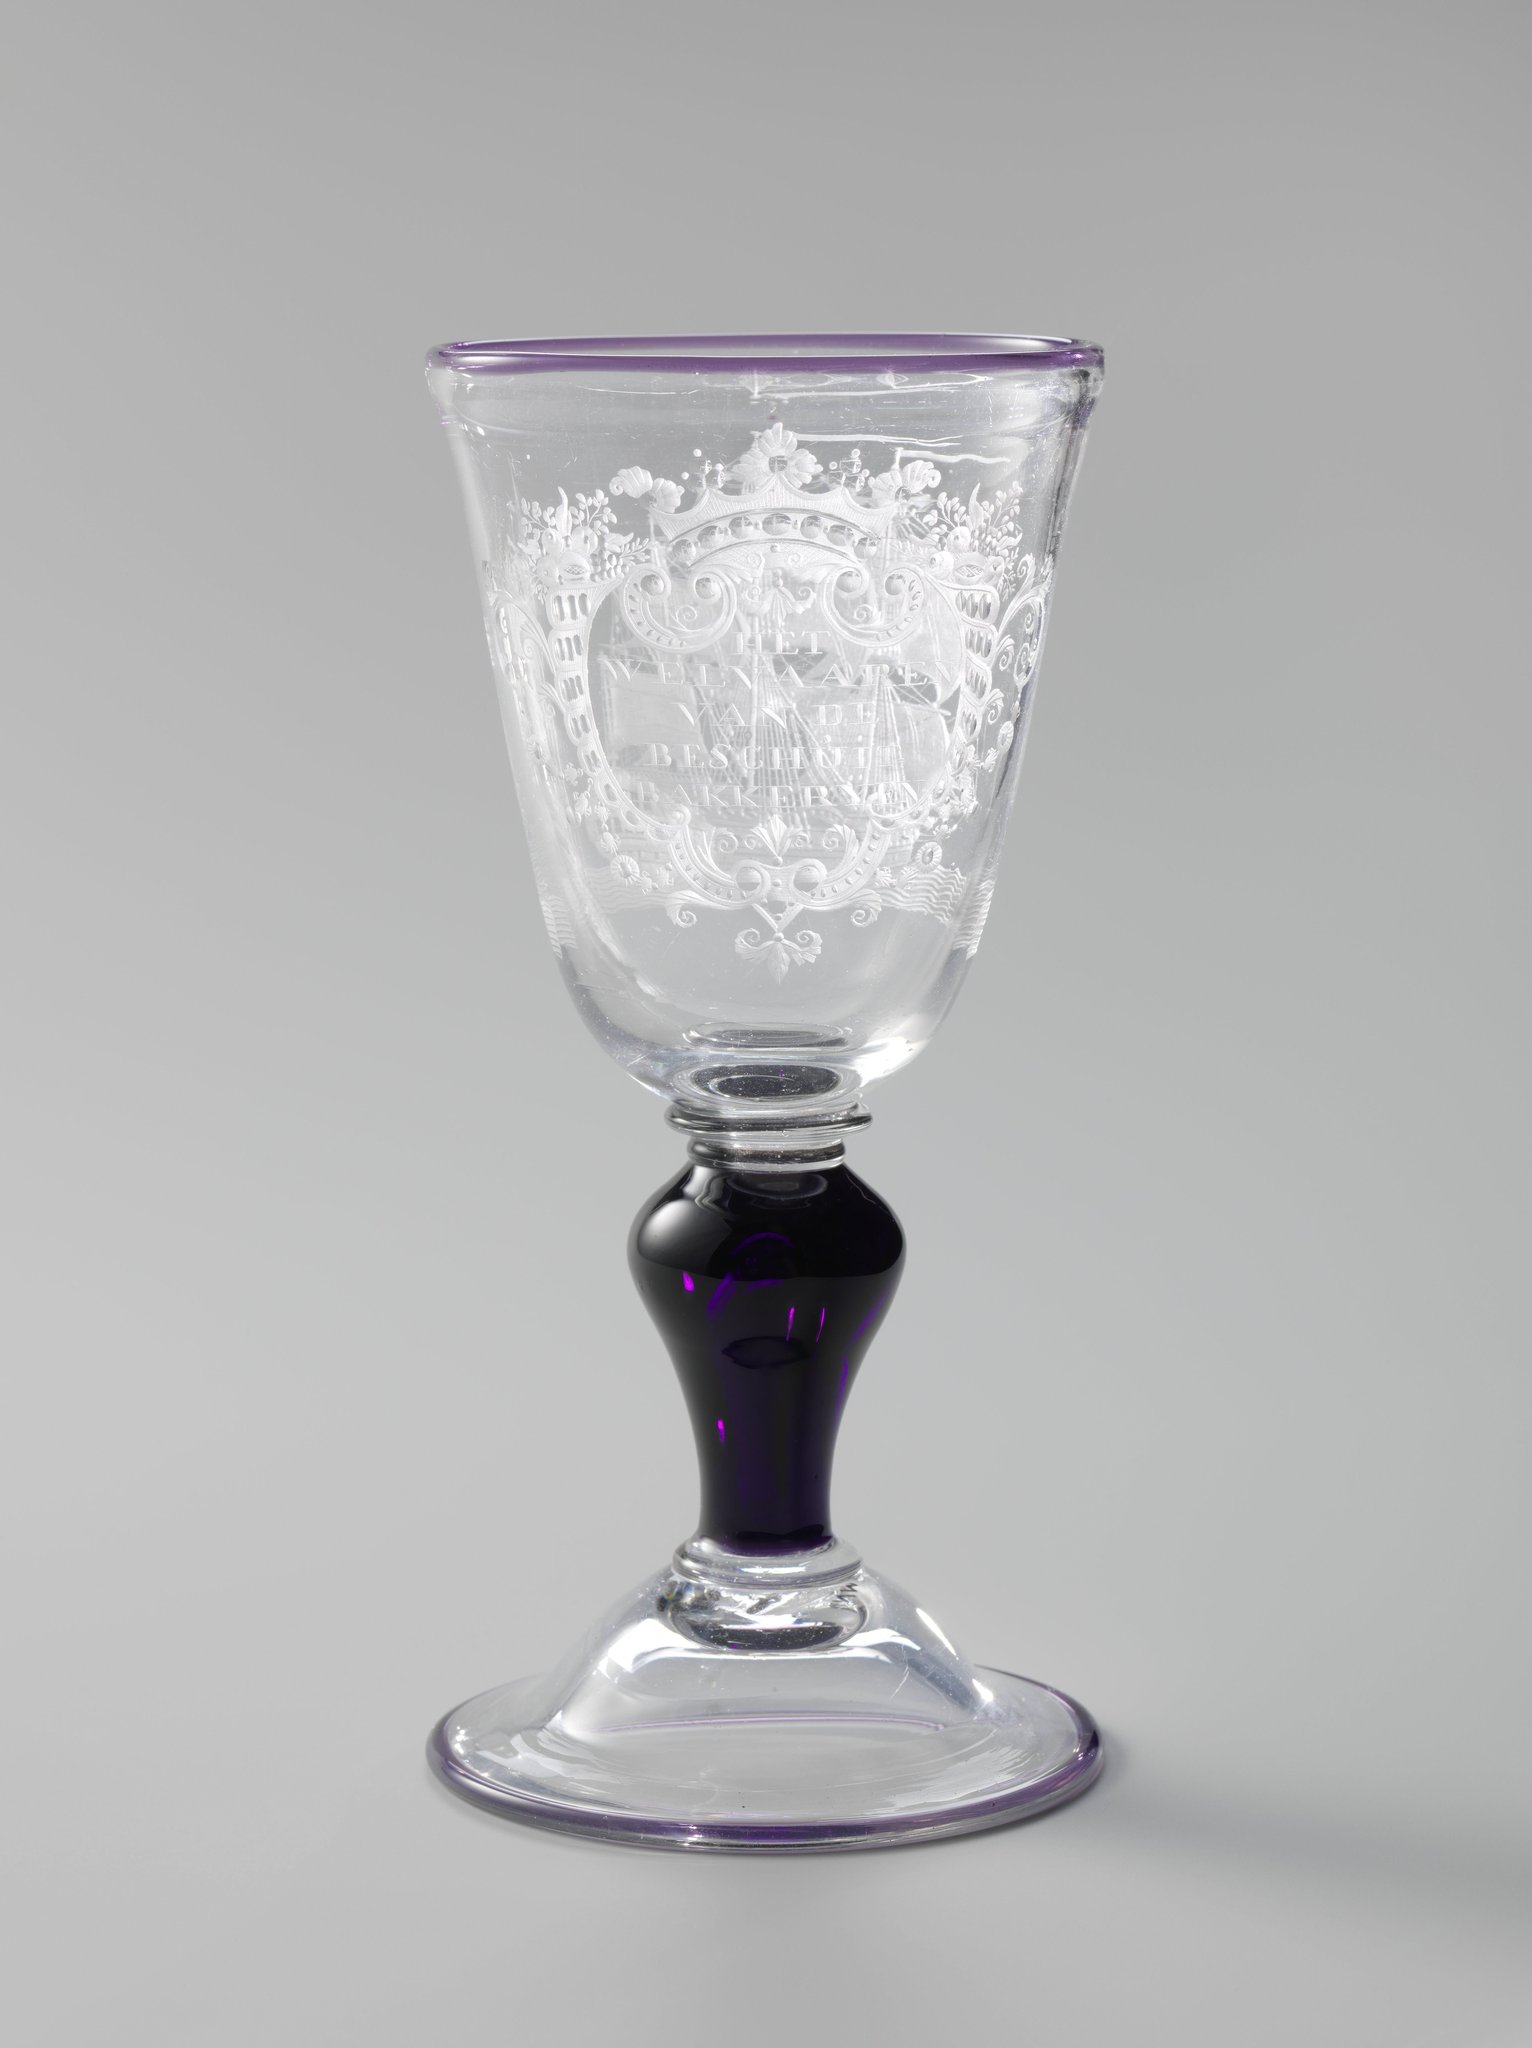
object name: goblet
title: Wine glass with a ship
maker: Anonymous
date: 1700-1725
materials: glass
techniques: glassblowing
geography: northern netherlands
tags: sailing-ship, sailing-boat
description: Welvaaren van de Beschuit Bakkeryen, ca. 1725 - 1750. Legaat L.D. Taunay, 1893.